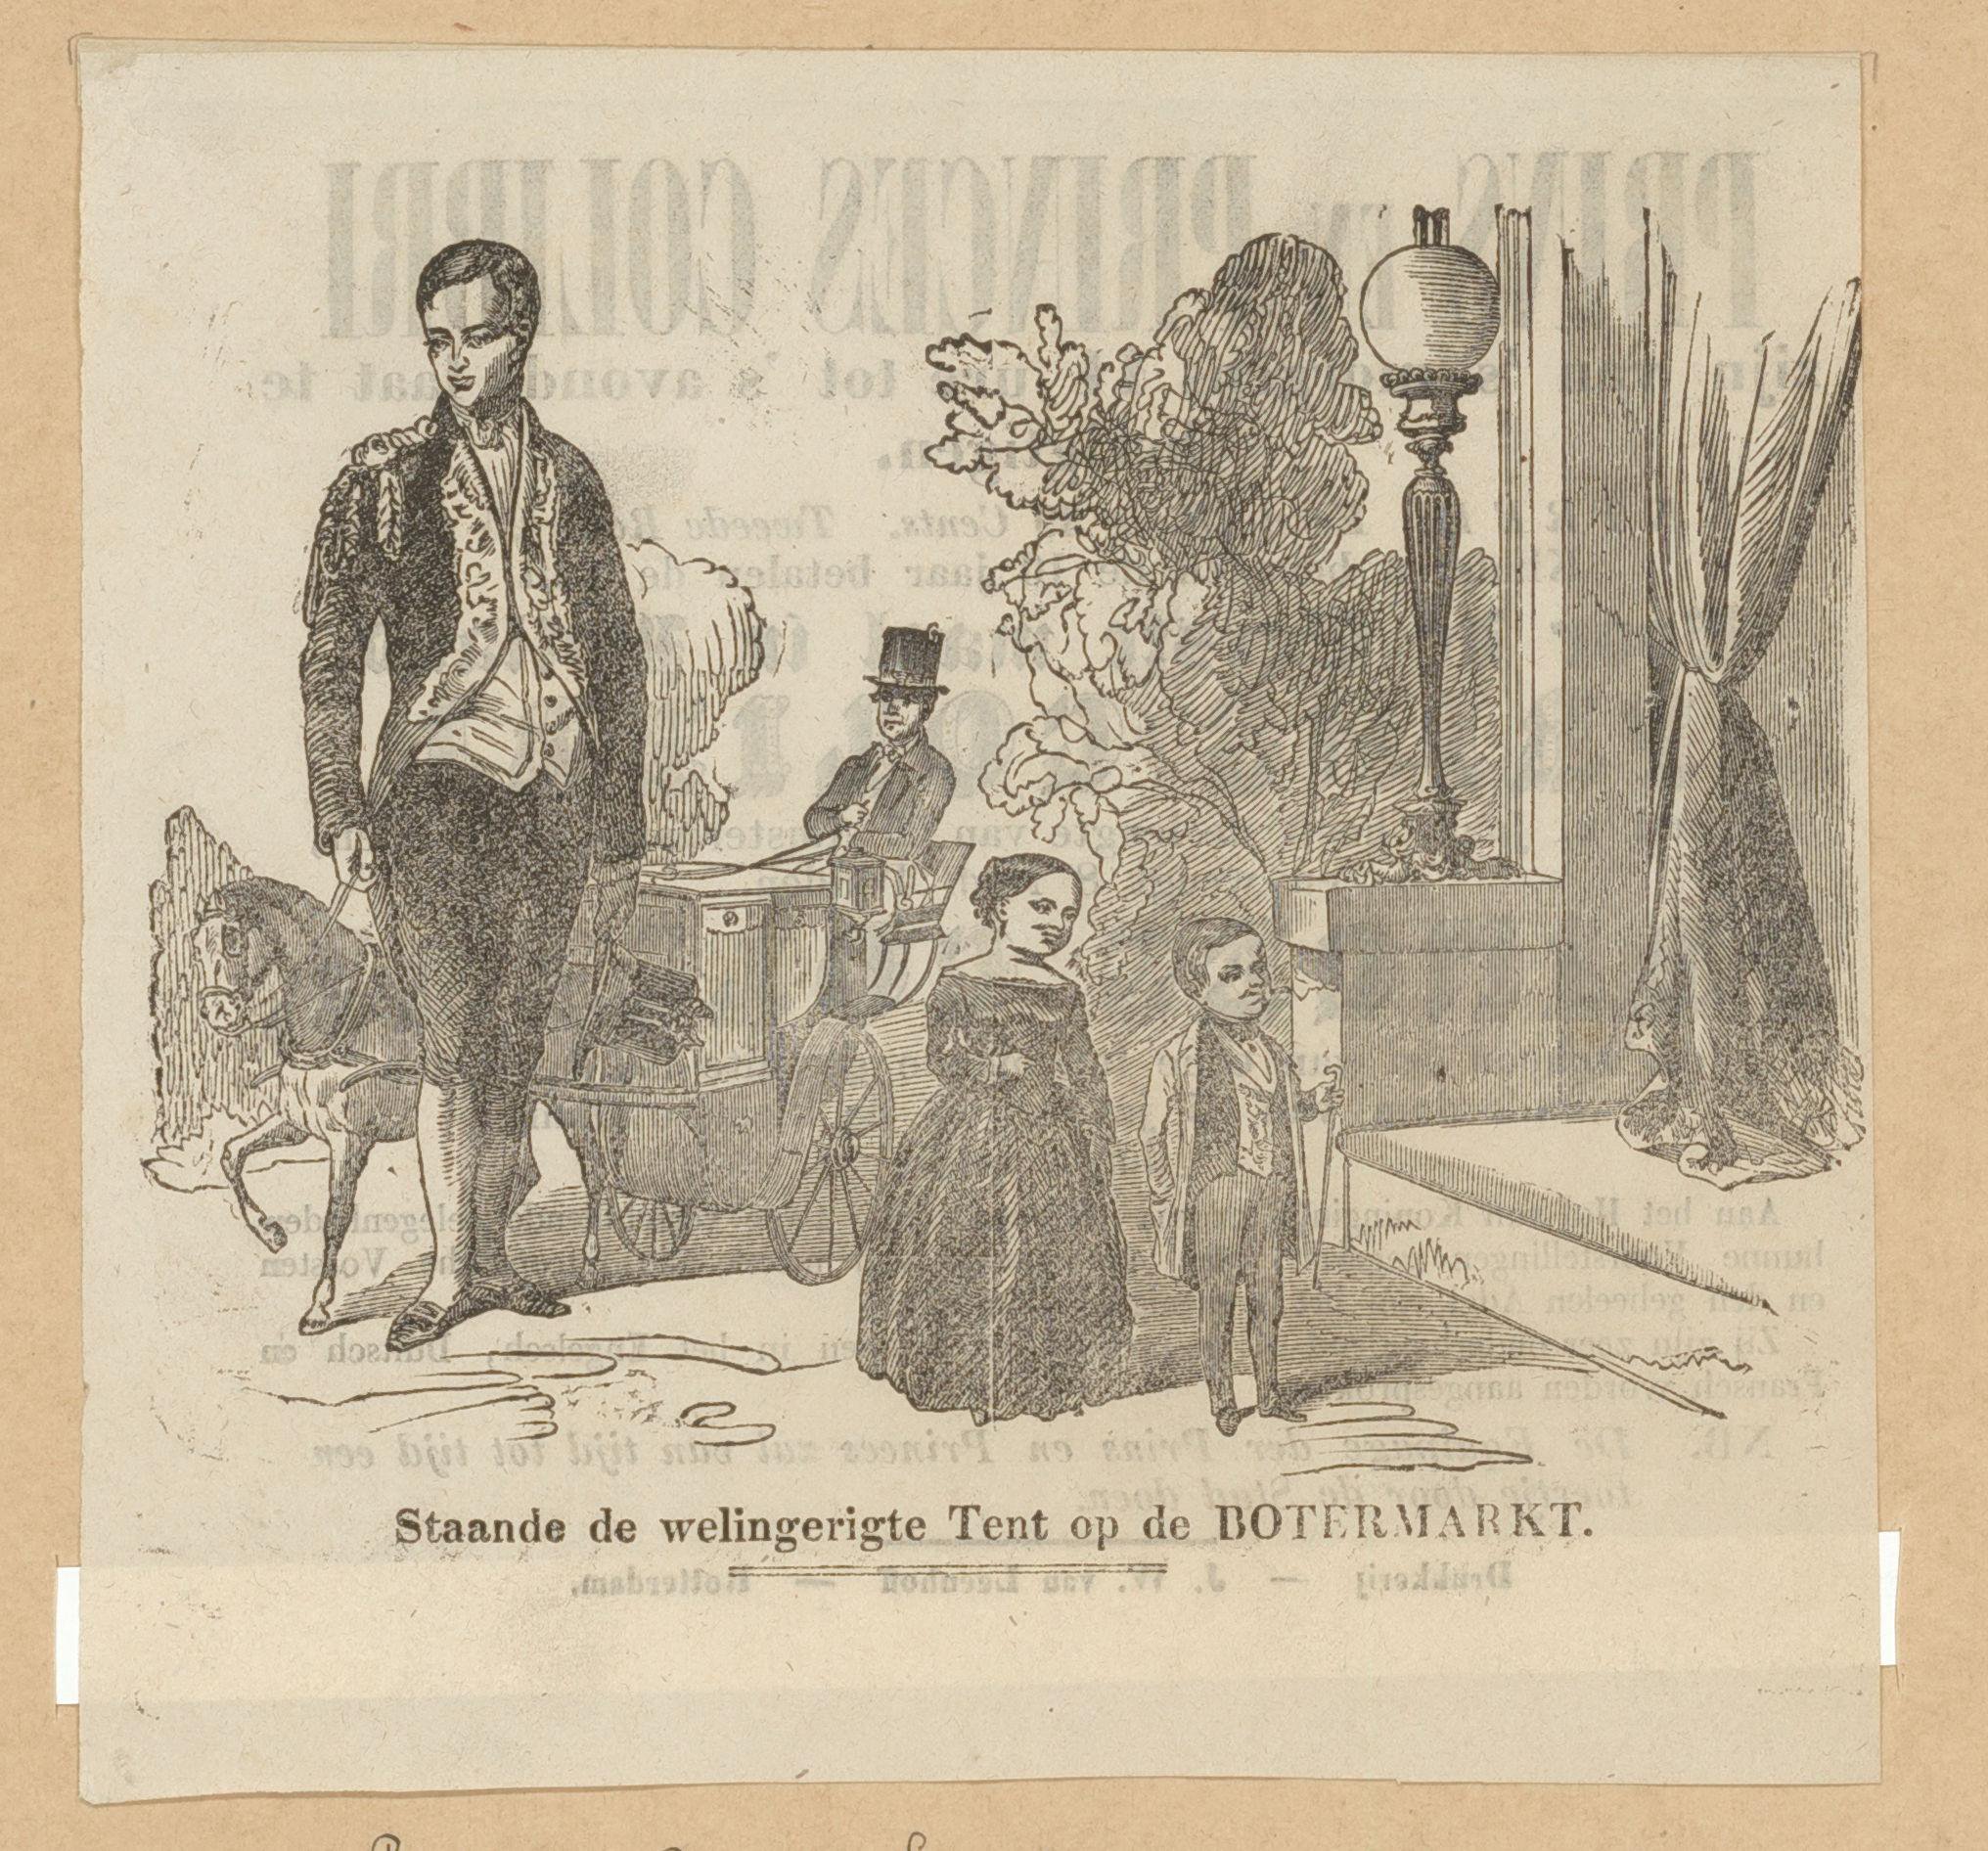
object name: print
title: Strooibiljet voor prins en prinses Colibri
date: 1850-1899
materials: paper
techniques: letterpress printing, engraving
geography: rotterdam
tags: little people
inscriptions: stamp, collector's mark: Lugt 1641, stamp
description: Strooibiljet voor prins en prinses Colibri. Zij traden op als kleine personen. Onderwerpsrubrieken binnen de Atlas Zeden en Gewoonten: Zeden en Gewoonten in Engeren Zin. Volksleven. Volksfeesten. Kermistypen, wondermenschen en dergelijken.